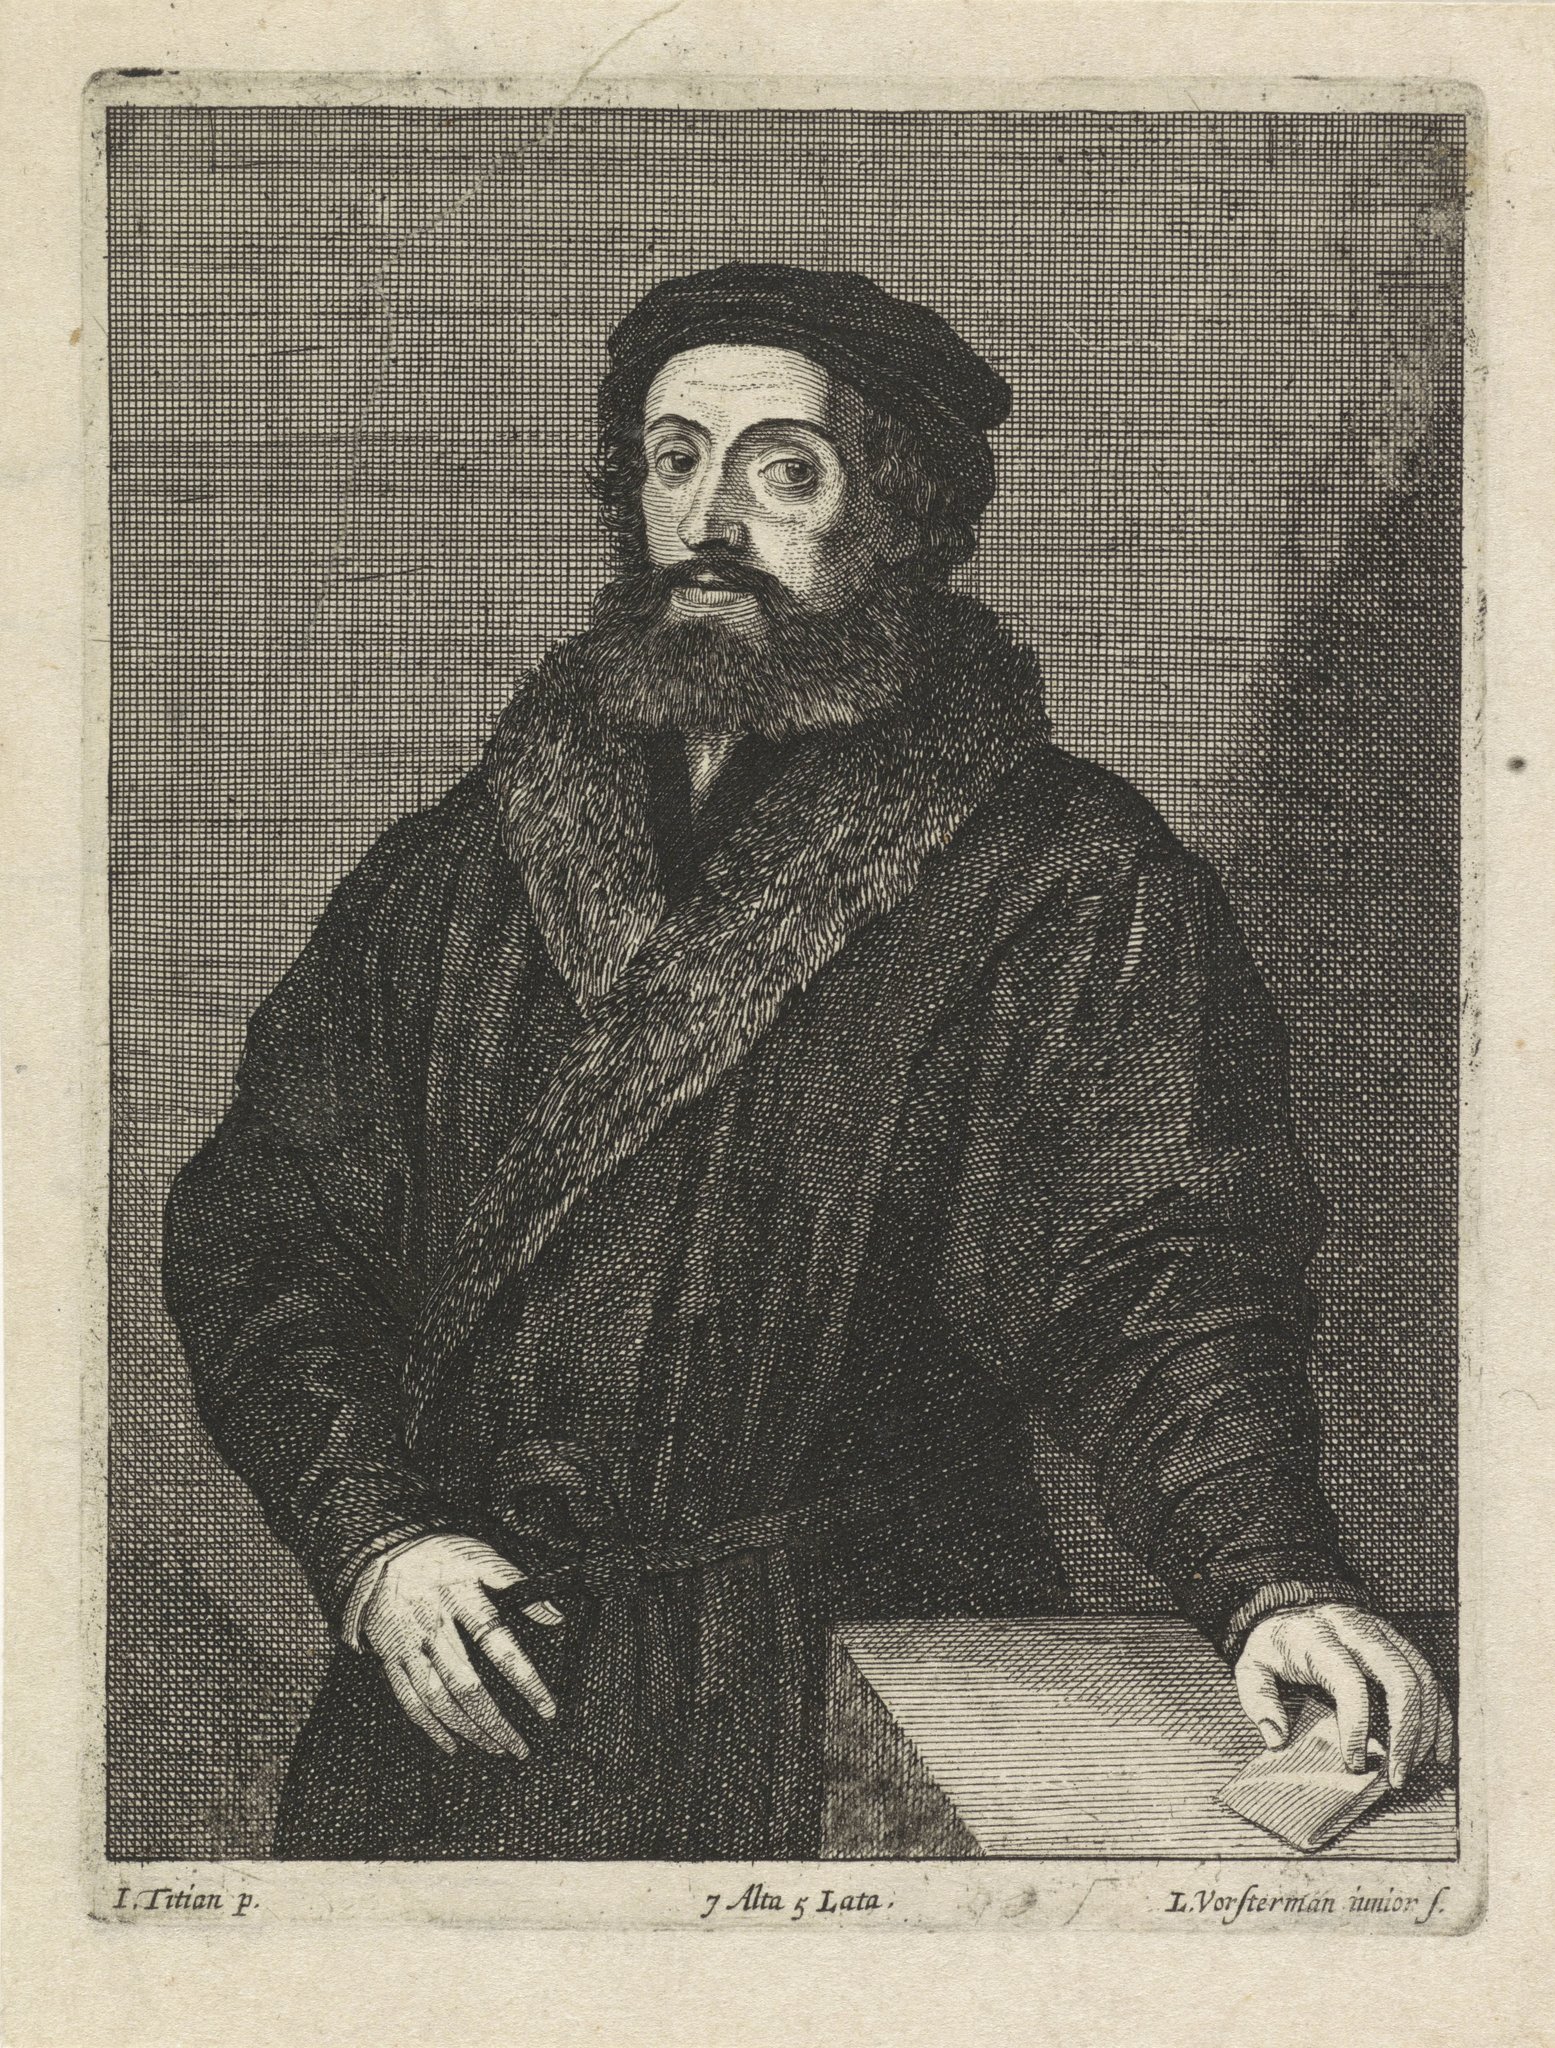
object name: print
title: Portret van een onbekende man, bij een tafel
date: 1651-1652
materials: paper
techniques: engraving, etching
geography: antwerp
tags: adult man, table, letter, envelope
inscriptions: collector's mark: Lugt 2228